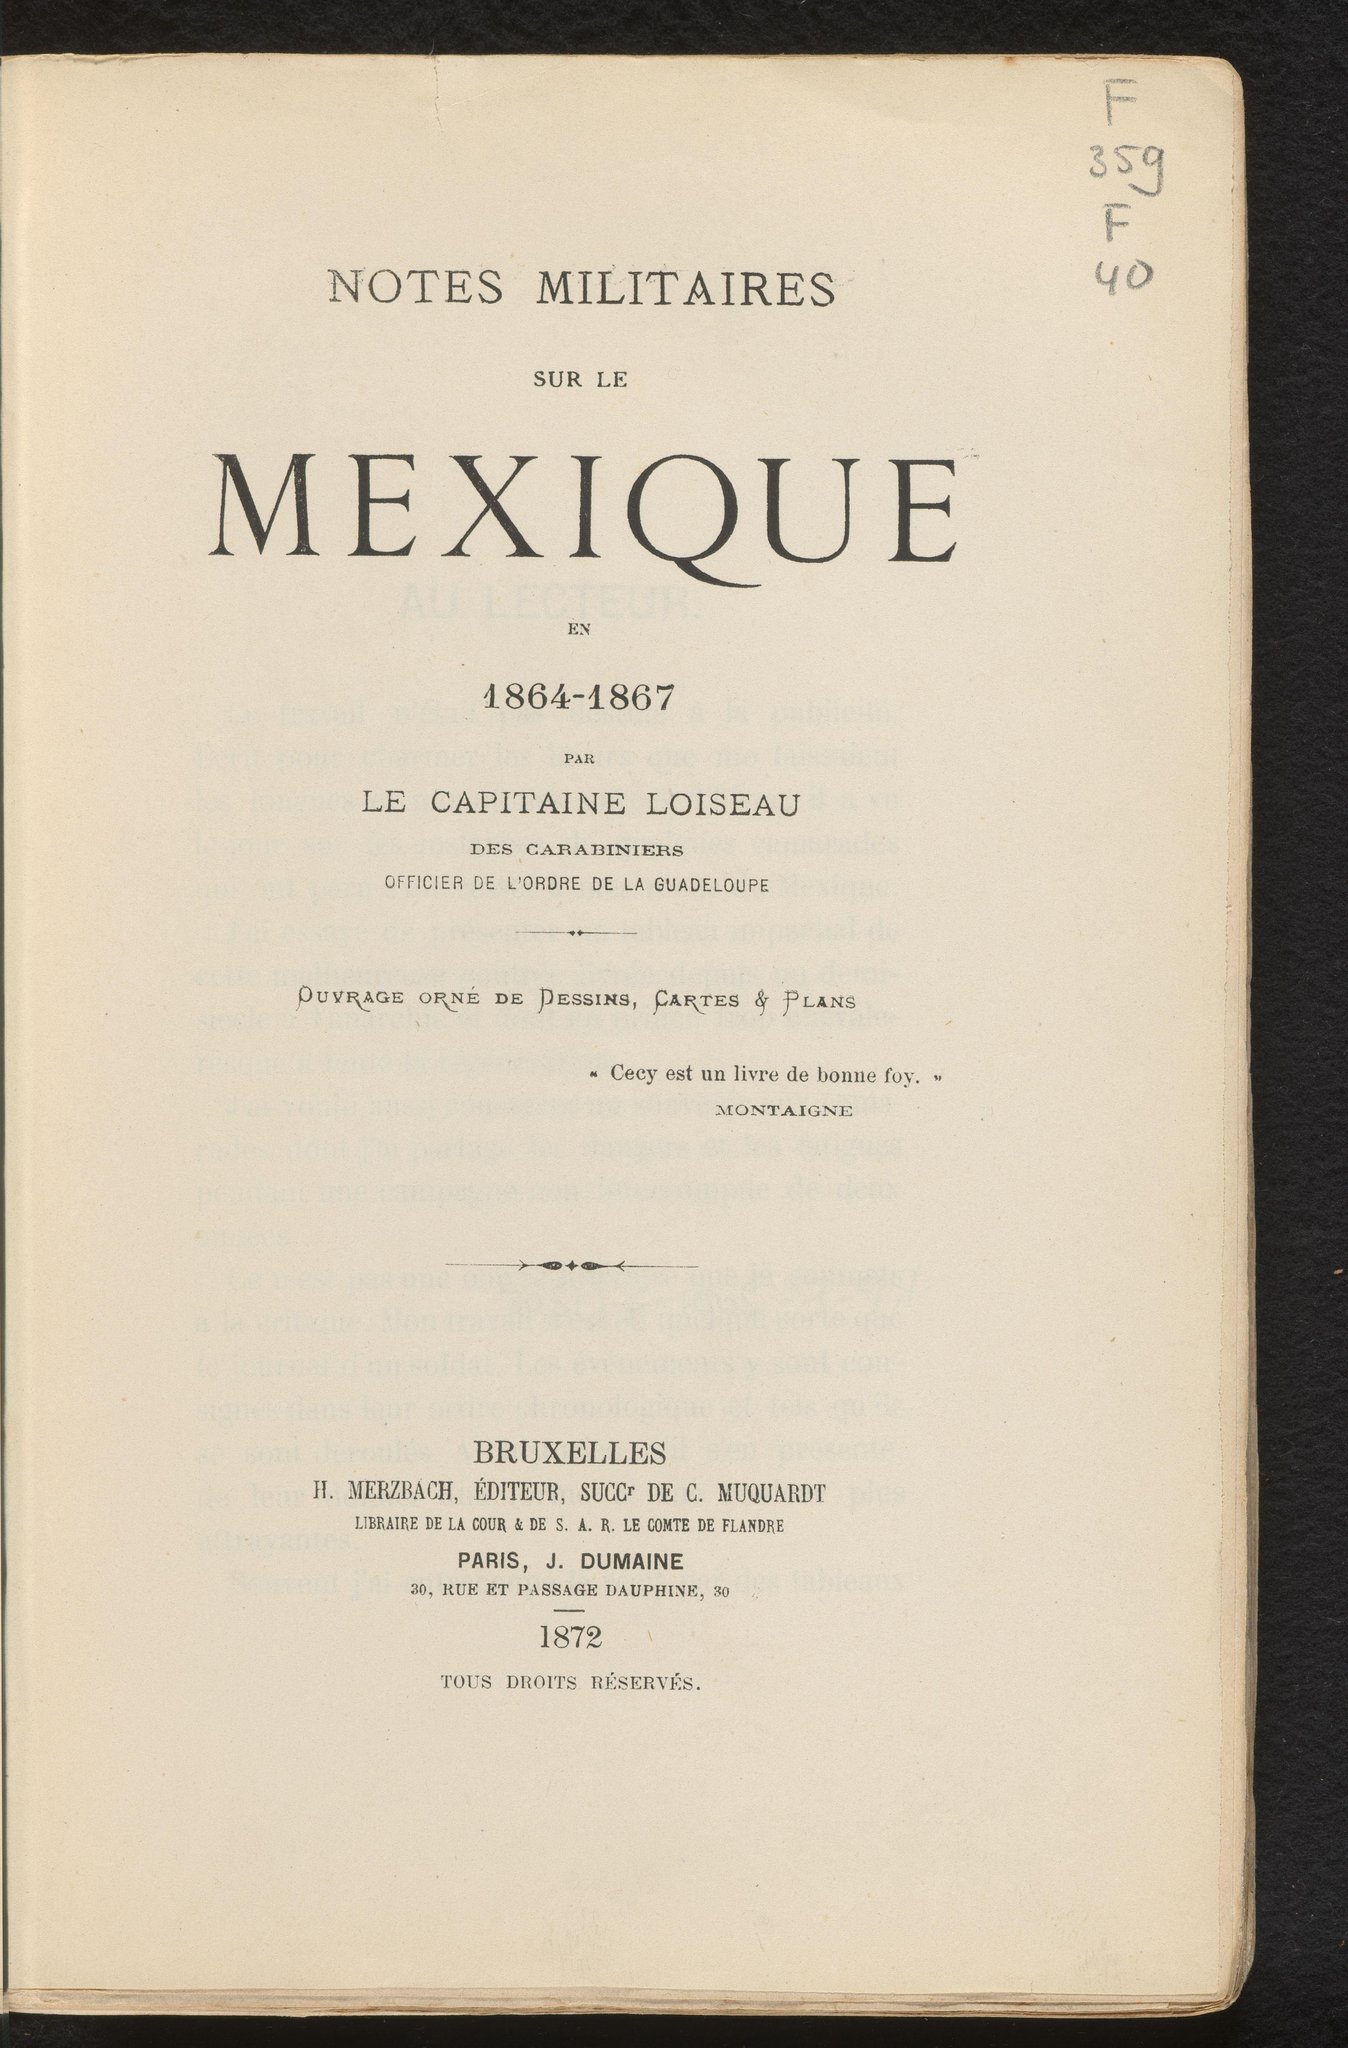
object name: book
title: Notes militaires sur le Mexique en 1864-1867 / par Loiseau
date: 1872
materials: cardboard, paper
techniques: photolithography, printing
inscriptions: bookplate: ‘EX/ SFJ/ LIBRIS’, annotation: ‘AUG 1983’